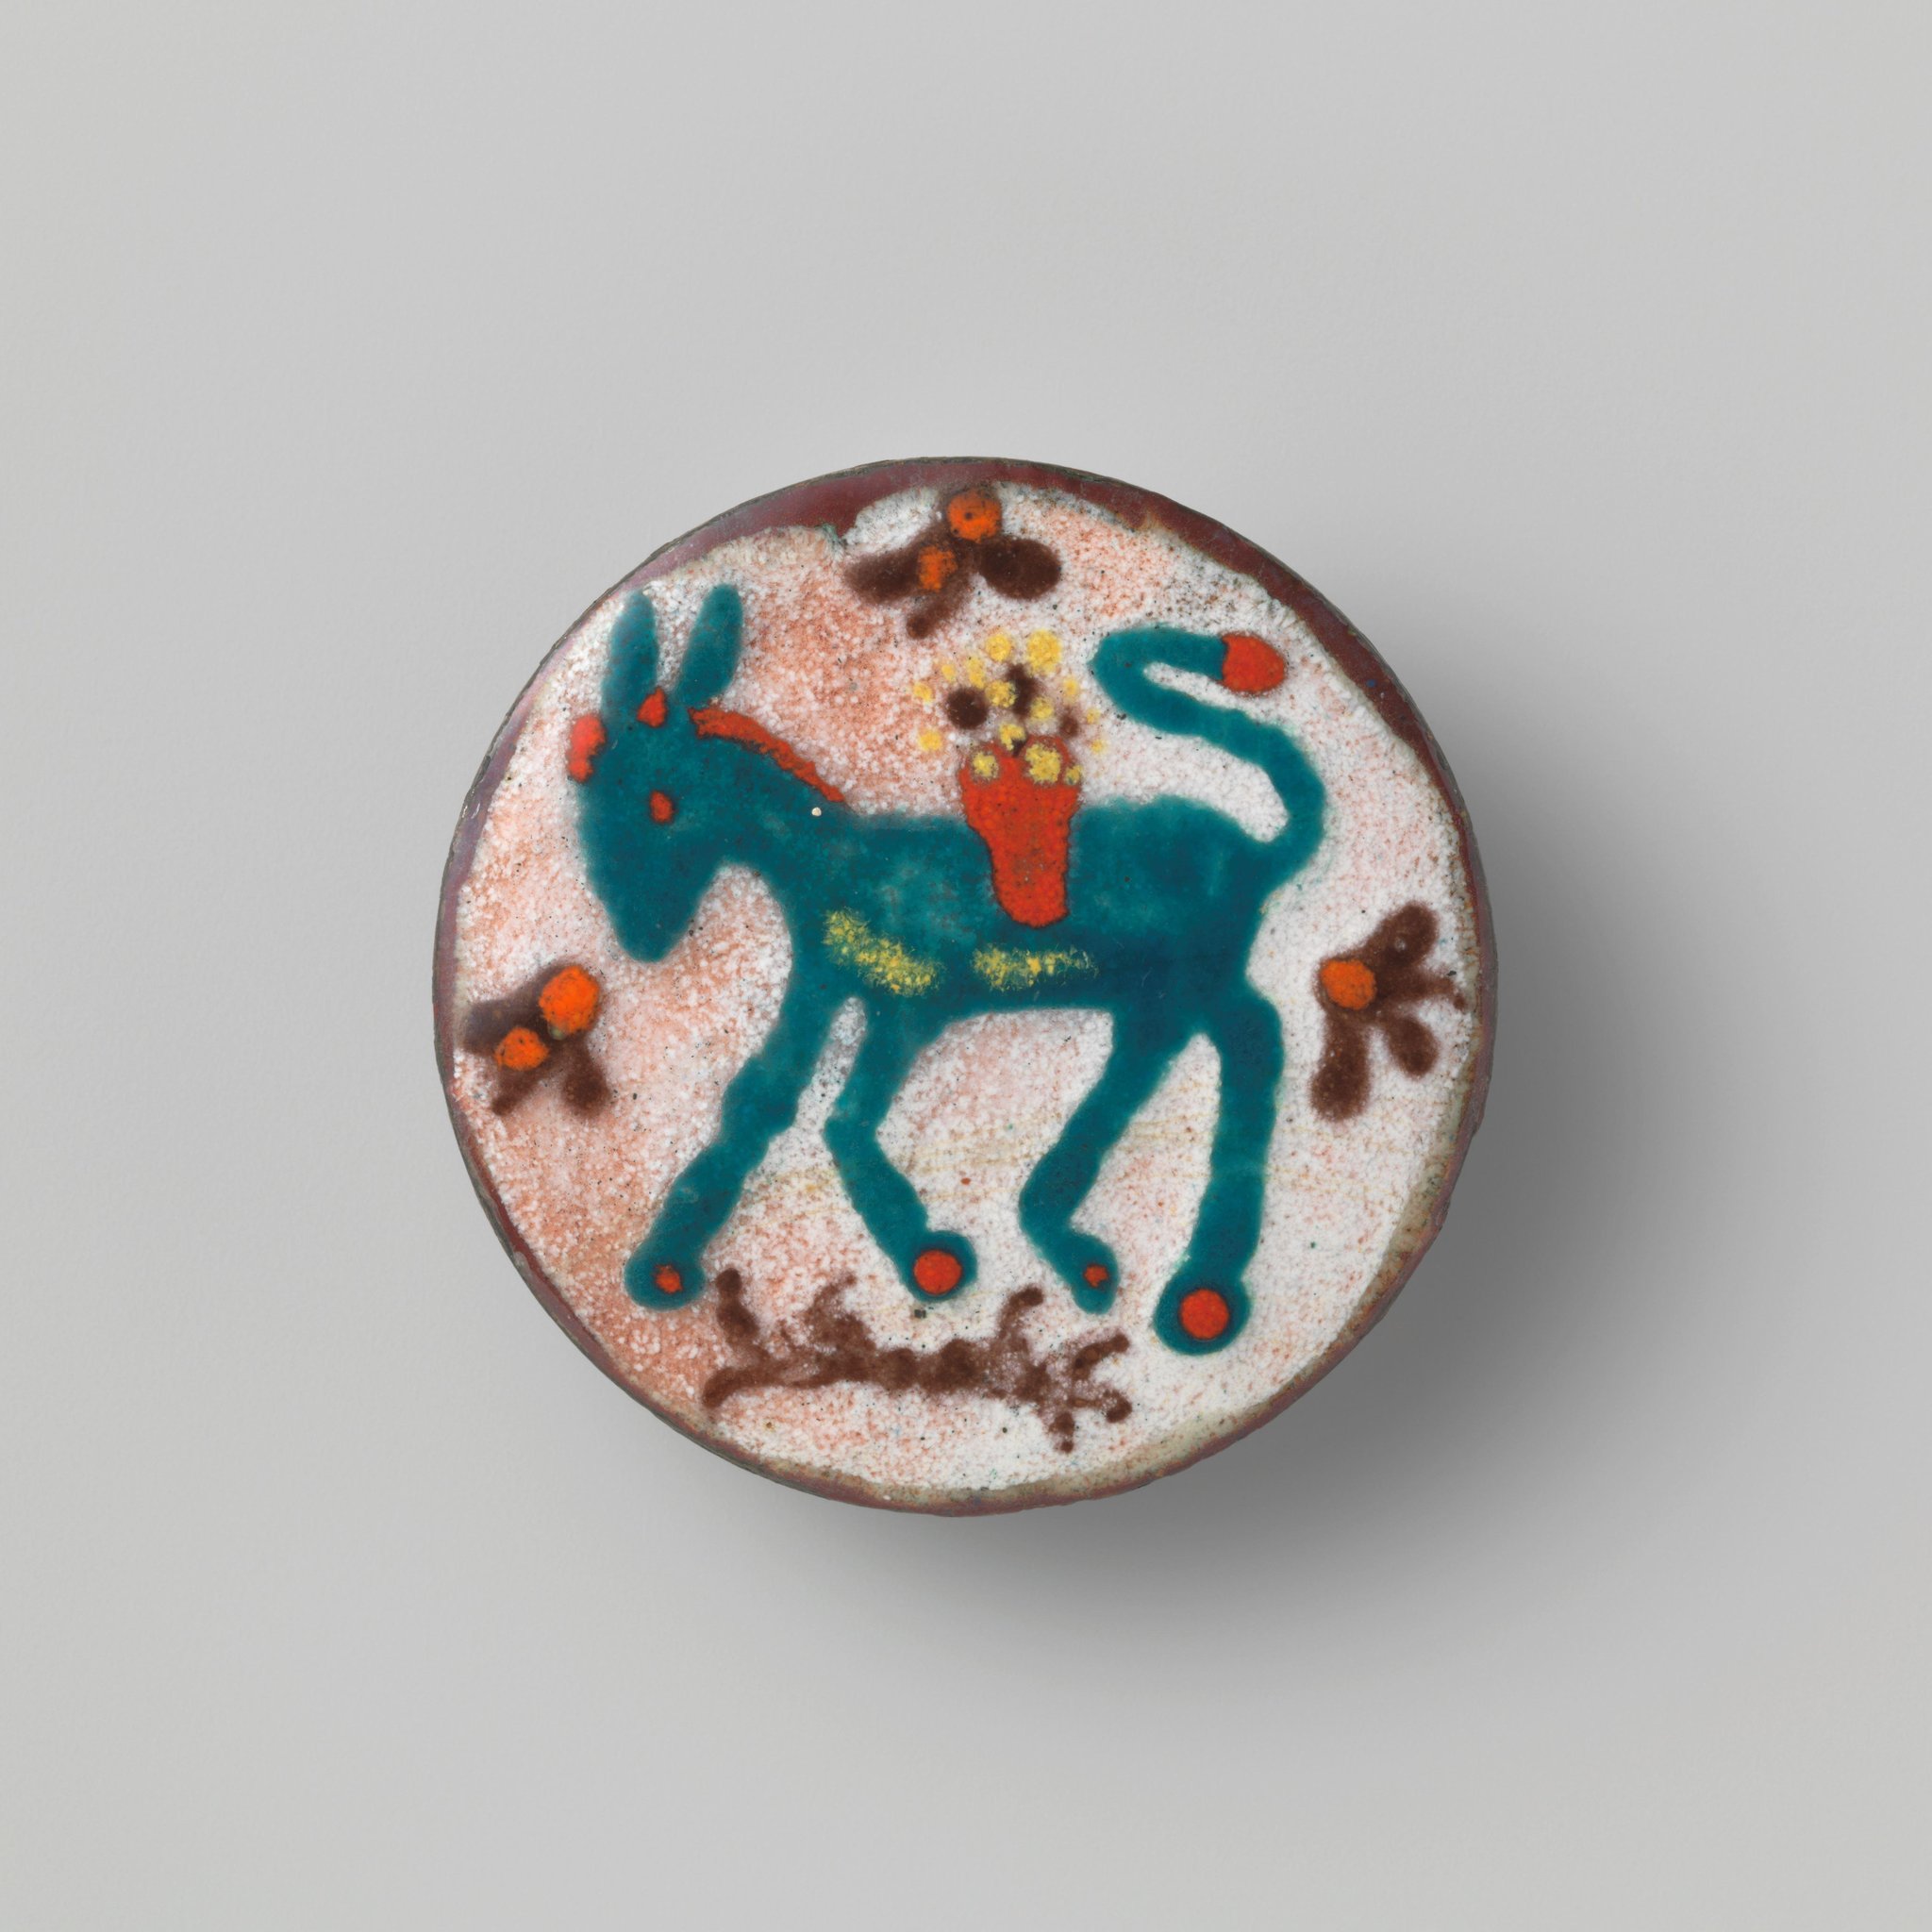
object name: brooch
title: Ronde broche van email op koper met ezel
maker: Anonymous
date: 1950-1960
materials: copper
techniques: enameling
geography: netherlands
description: Ronde broche van email op koper voorzien van een haaksluiting. De ezel is blauwgroen met rode details op een grond van wit en zalmrose. Het geheel is bruin omrand.